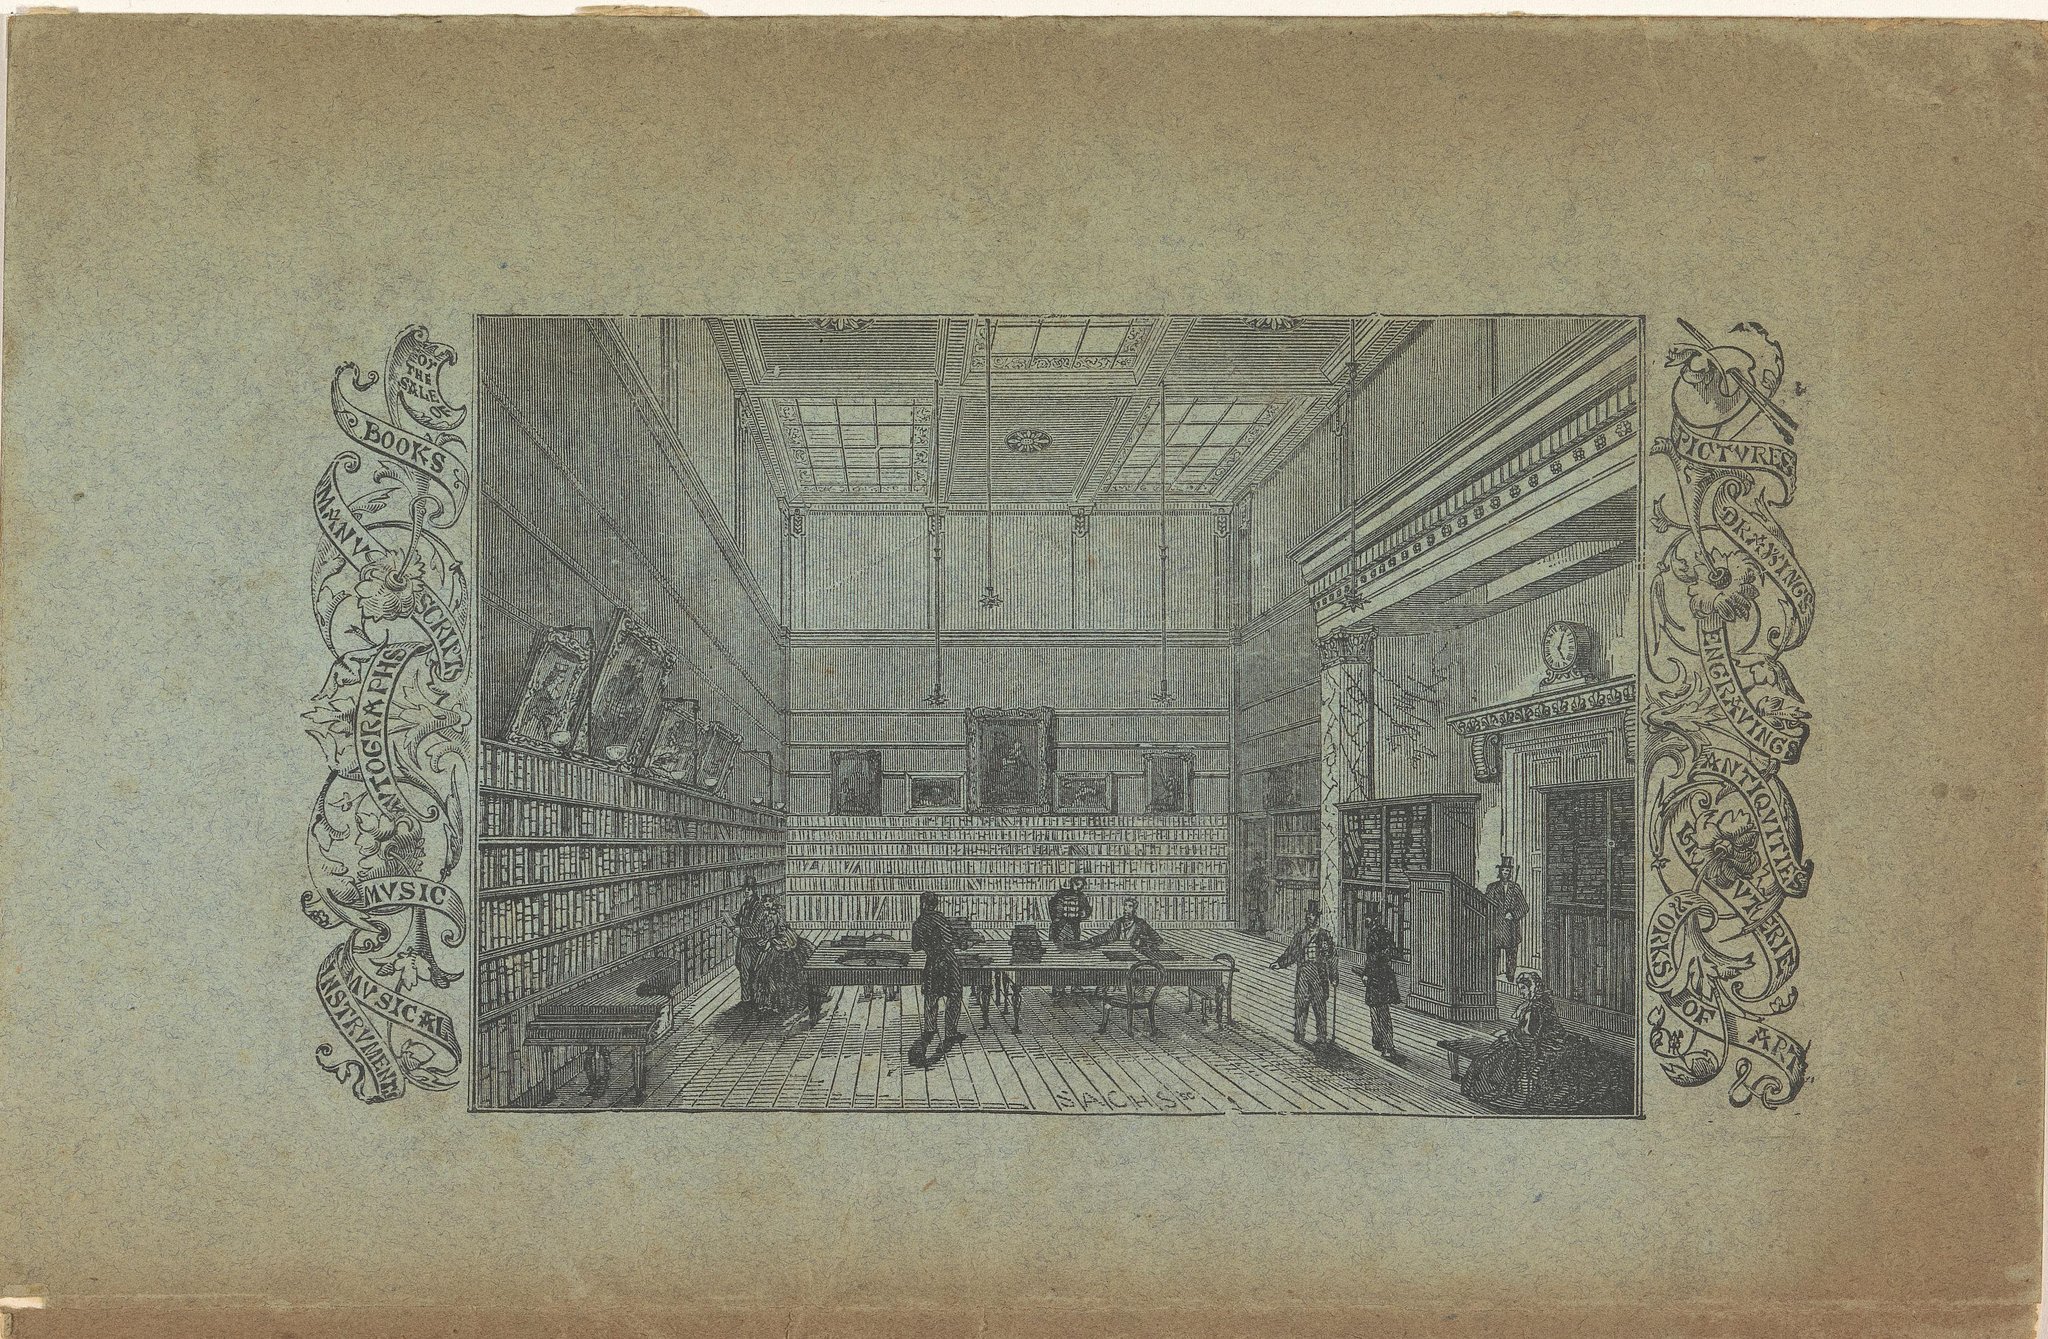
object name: print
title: Veilingzaal van Puttick and Simpson te Londen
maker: sachs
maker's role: print maker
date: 1882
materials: cardboard, paper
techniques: engraving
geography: london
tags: bookshelves, grand piano, picture, painting, art sale, auction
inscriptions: collector's mark: Lugt 2228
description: Zaal met boekenkasten langs de wanden met schilderijen er boven en in het midden een lange tafel. Links een vleugel en rechts een verhoging voor de veilingmeester. Links en rechts van de afbeelding een decoratieve border met vermelding van de zaken die bij Puttick and Simpson geveild worden.